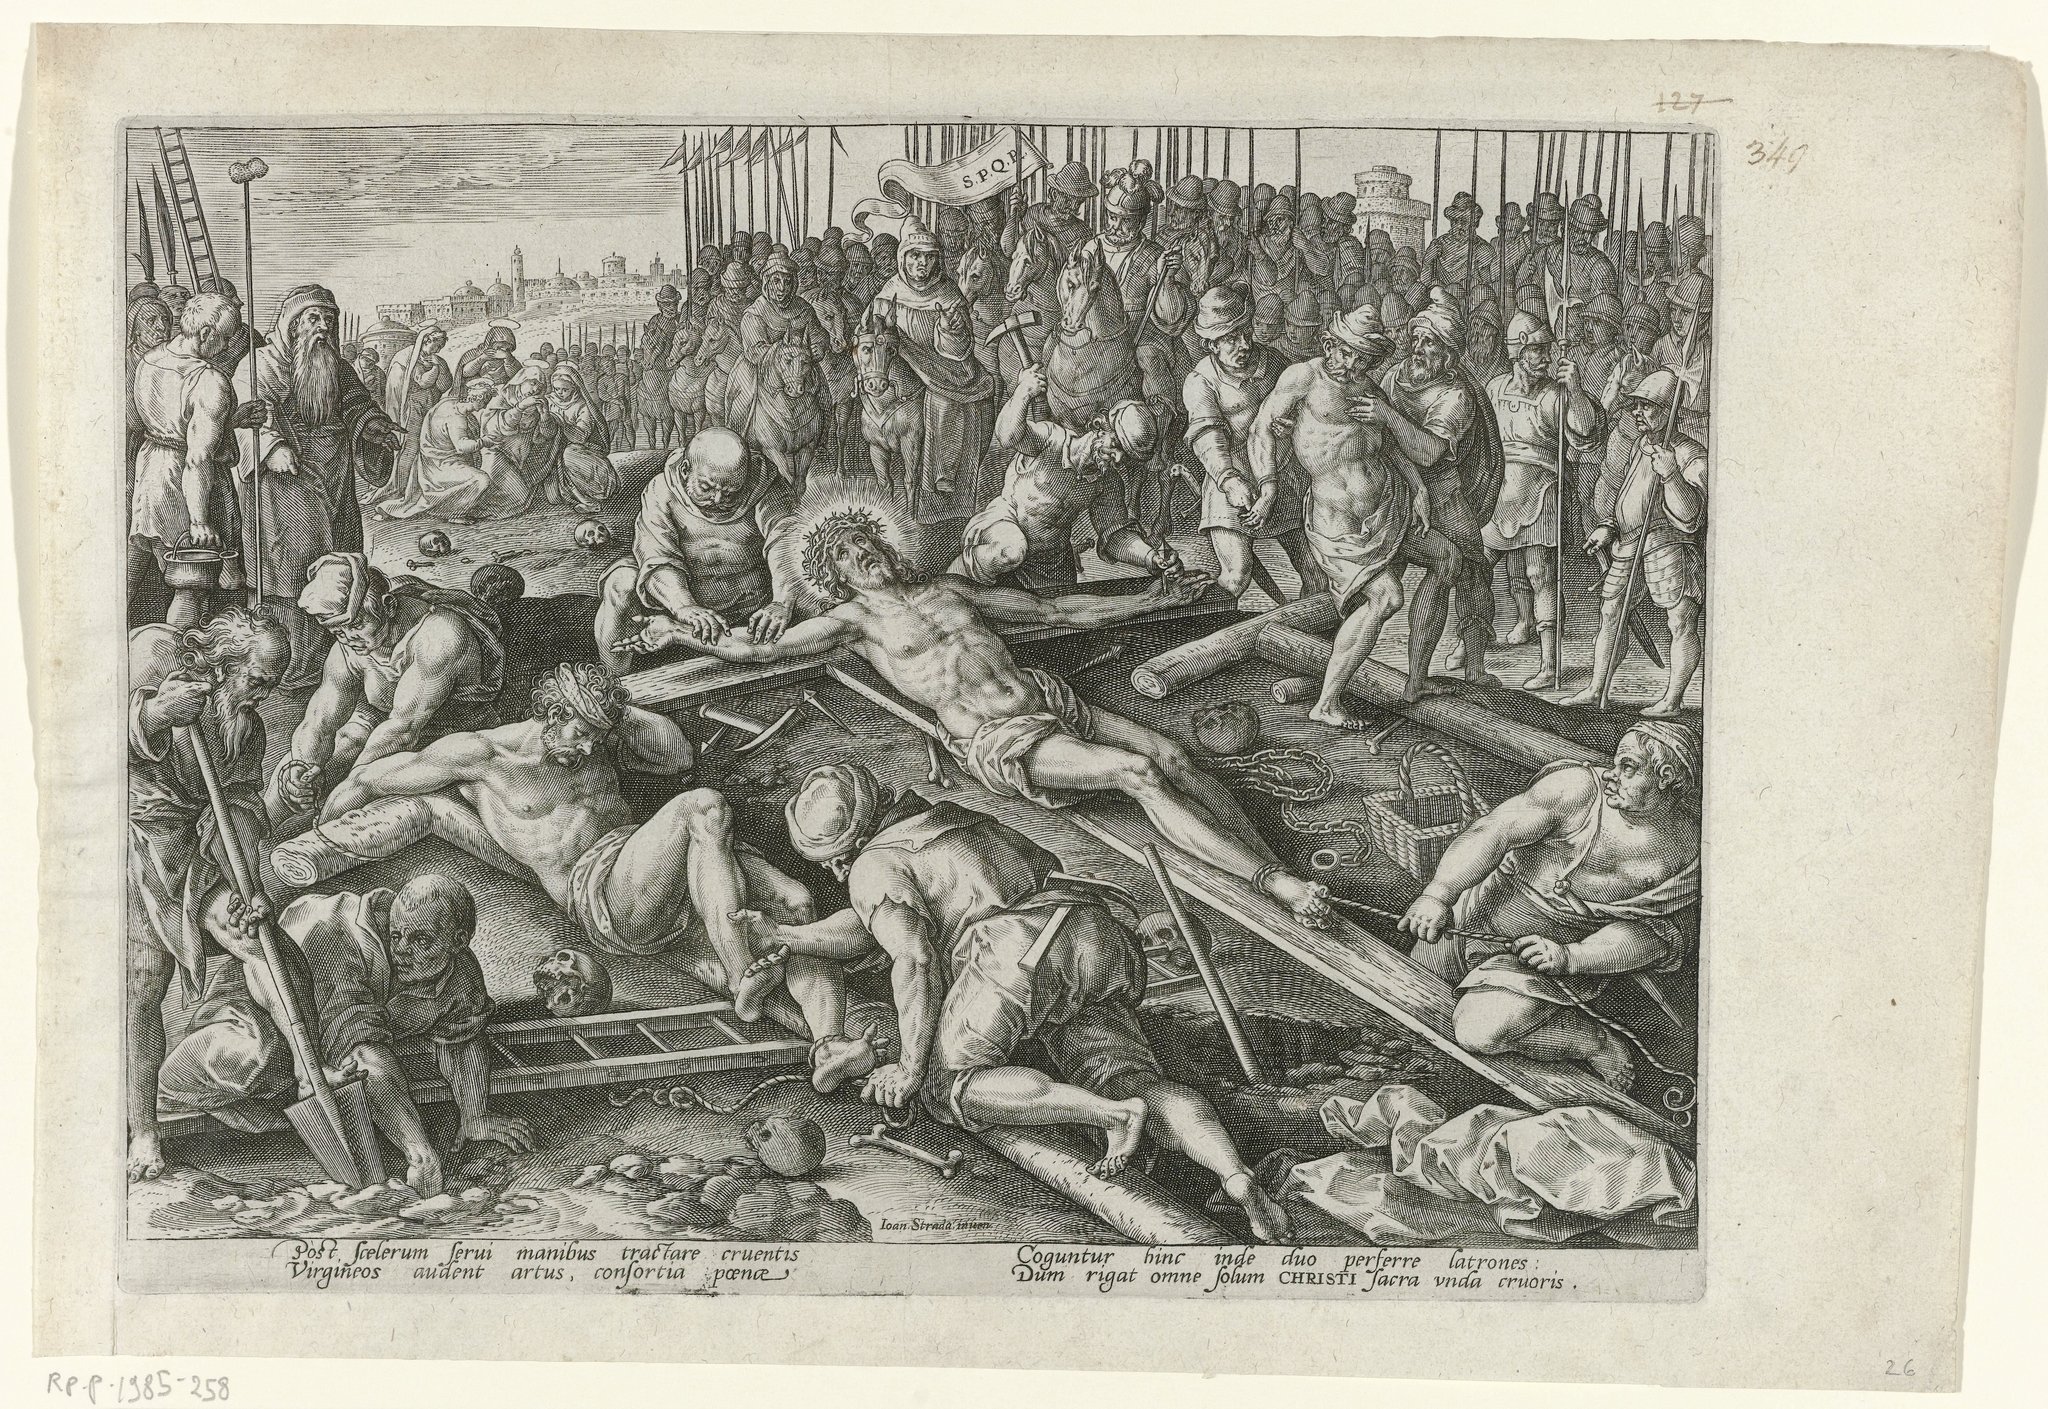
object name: print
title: Kruisiging van Christus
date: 1585-1586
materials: paper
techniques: engraving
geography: florence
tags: the erection of the cross: christ is nailed to the cross which lies on the ground (+ mary)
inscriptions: collector's mark: Lugt 2228, watermark:, number: ‘349’, collector's mark: 2760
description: Christus wordt aan het kruis genageld terwijl toeschouwer toekijken (Lucas 23:33). Ook de twee dieven worden aan hun kruisen gebonden.In de achtergrond de huilende Maria, getroost door Johannes en Maria Magdalena. De prent heeft een Latijns onderschrift en maakt deel uit van een serie over de passie, dood en wederopstanding van Christus.